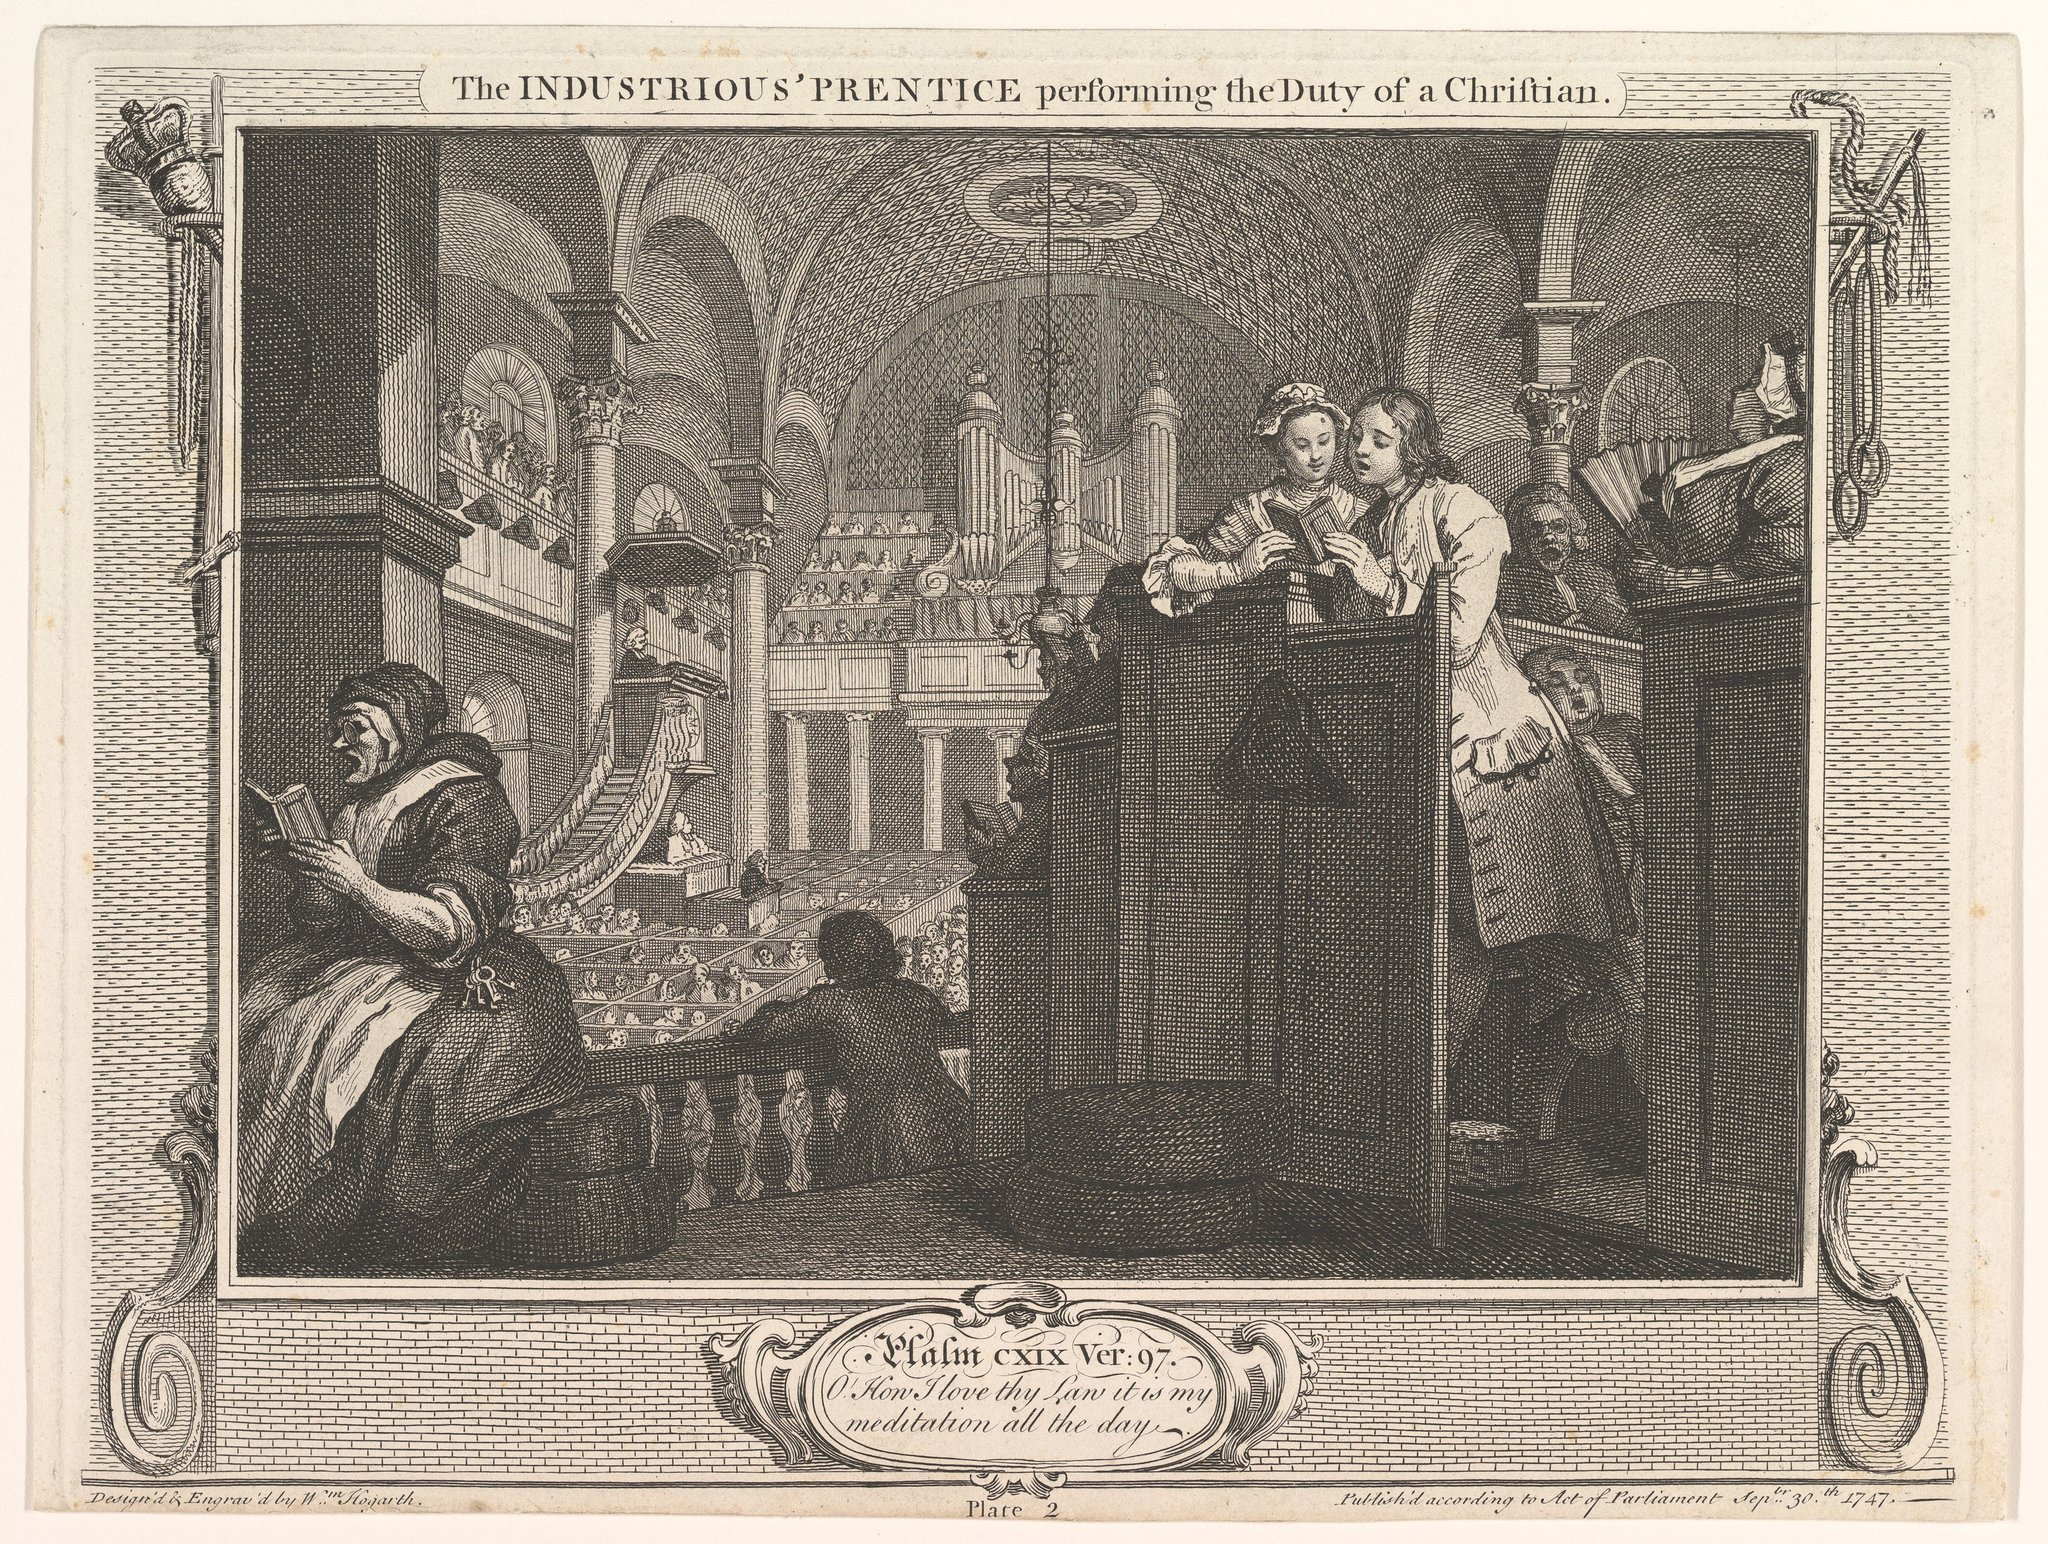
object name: print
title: The Industrious 'Prentice Performing the Duty of a Christian (Industry and Idleness, plate 2)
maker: william hogarth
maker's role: artist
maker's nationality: british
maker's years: 1697-1764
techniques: engraving, etching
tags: performance,girls,women,spectators